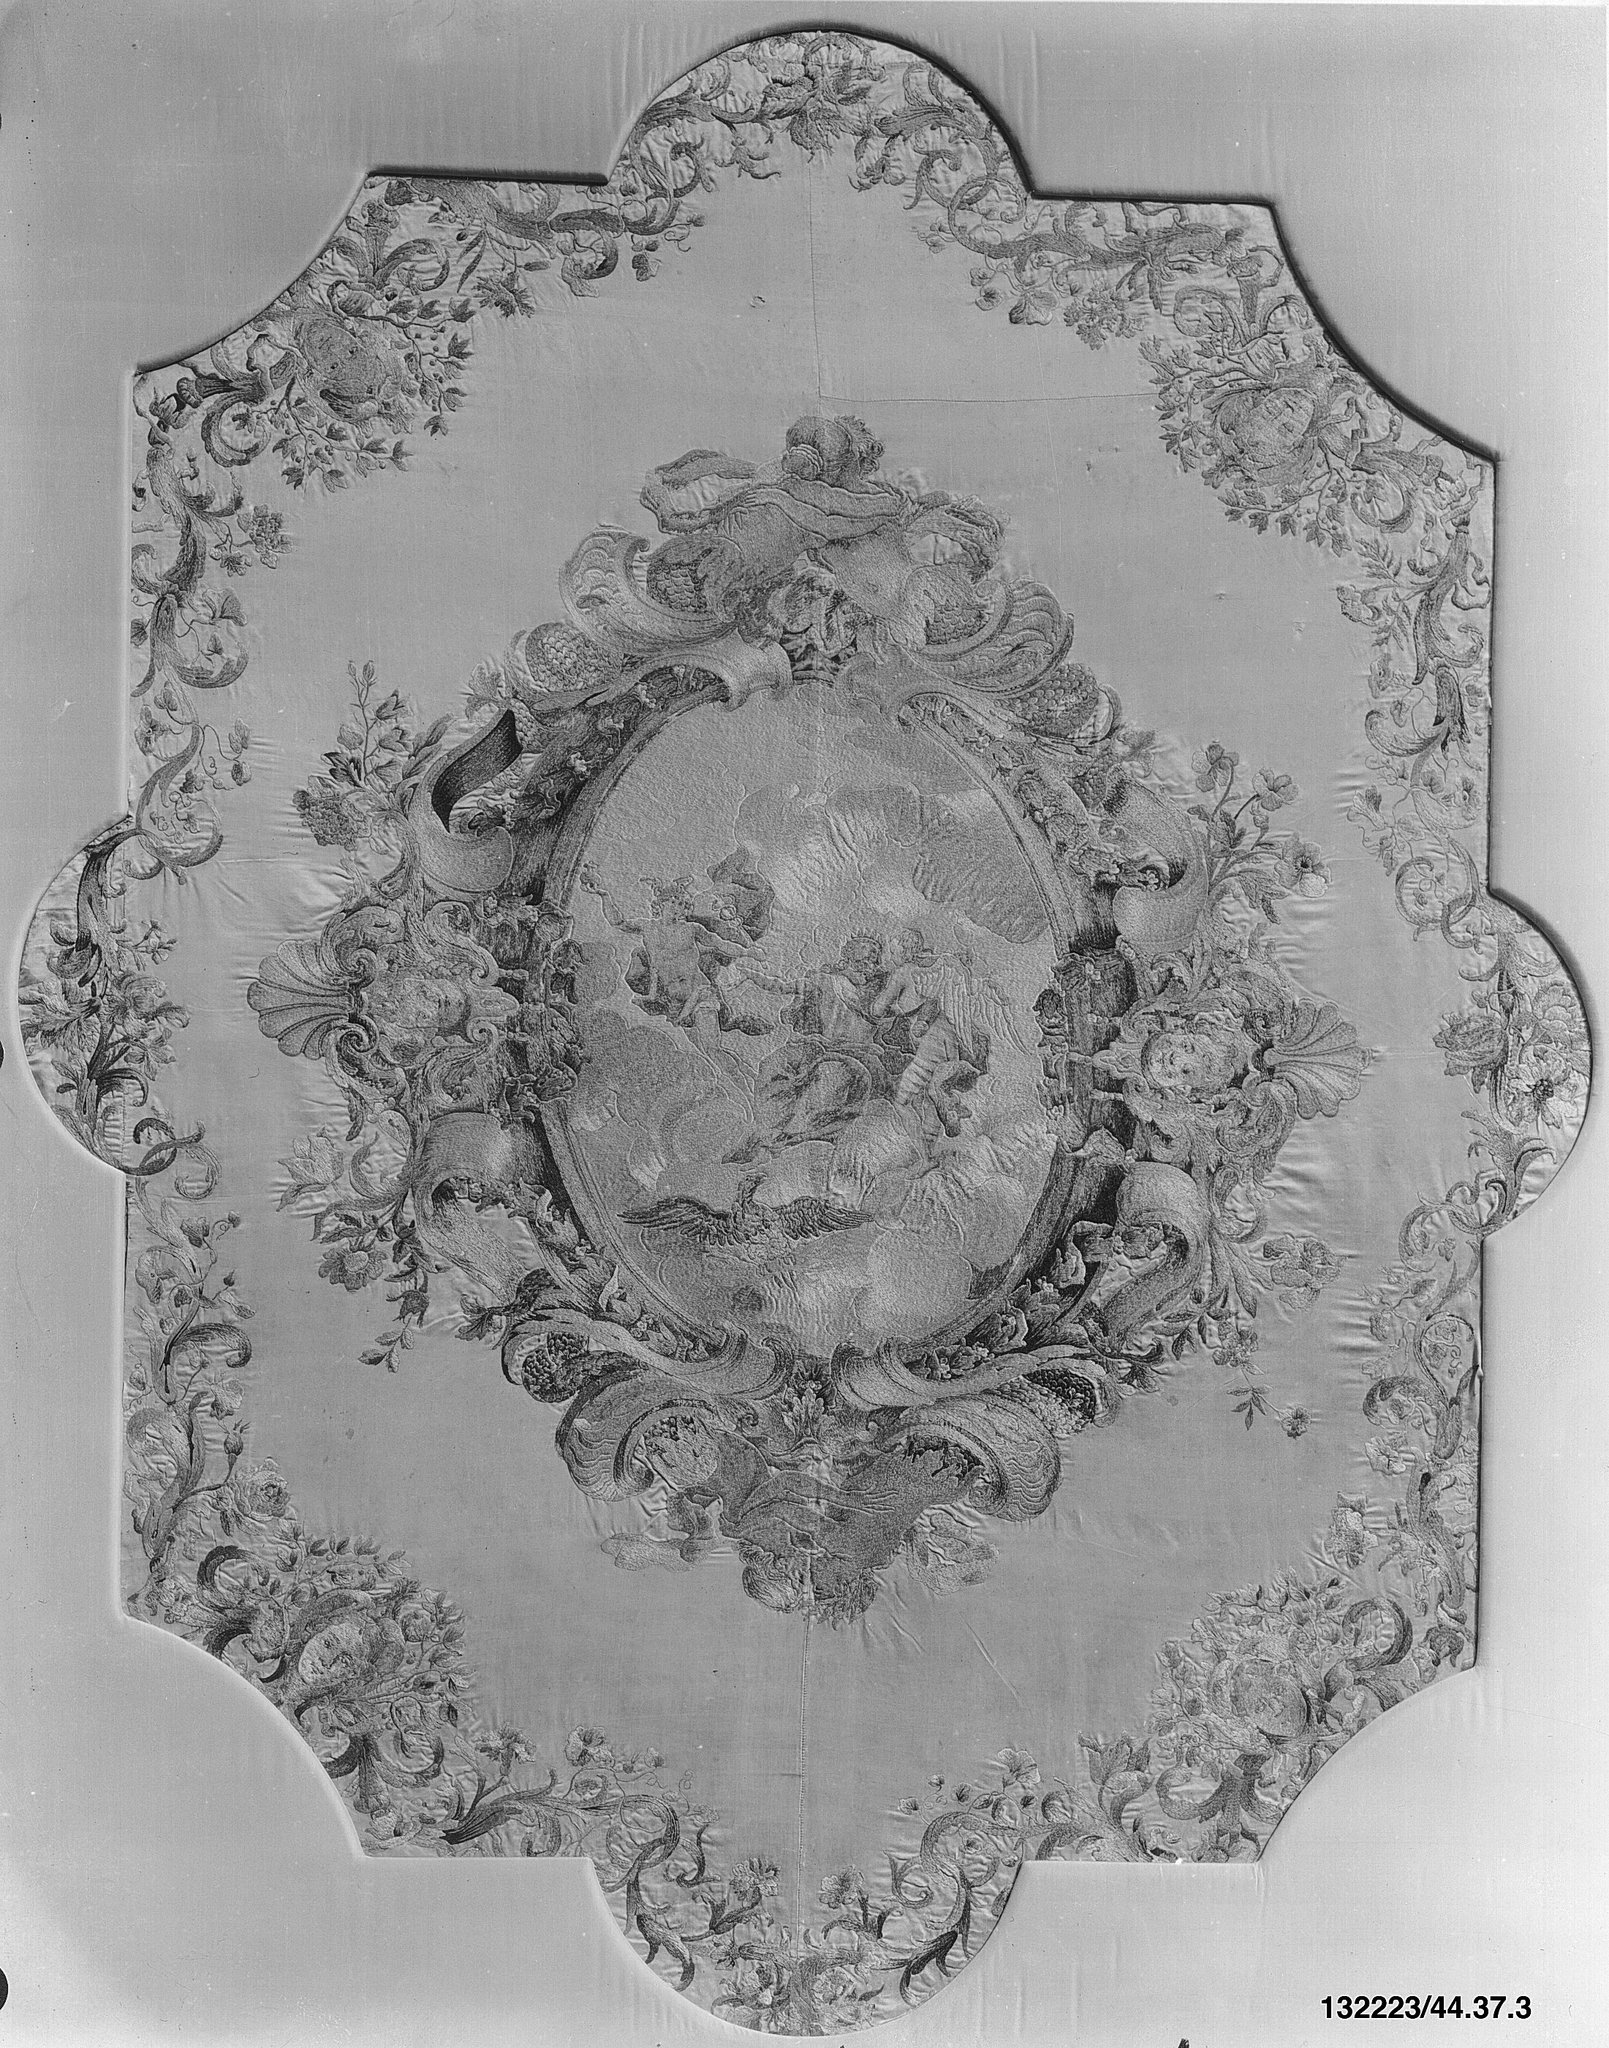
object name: panel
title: Upholstery panel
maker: daniel marot the elder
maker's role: maker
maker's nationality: french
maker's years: 1661-1752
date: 1701-1733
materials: silk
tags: cupid,mercury